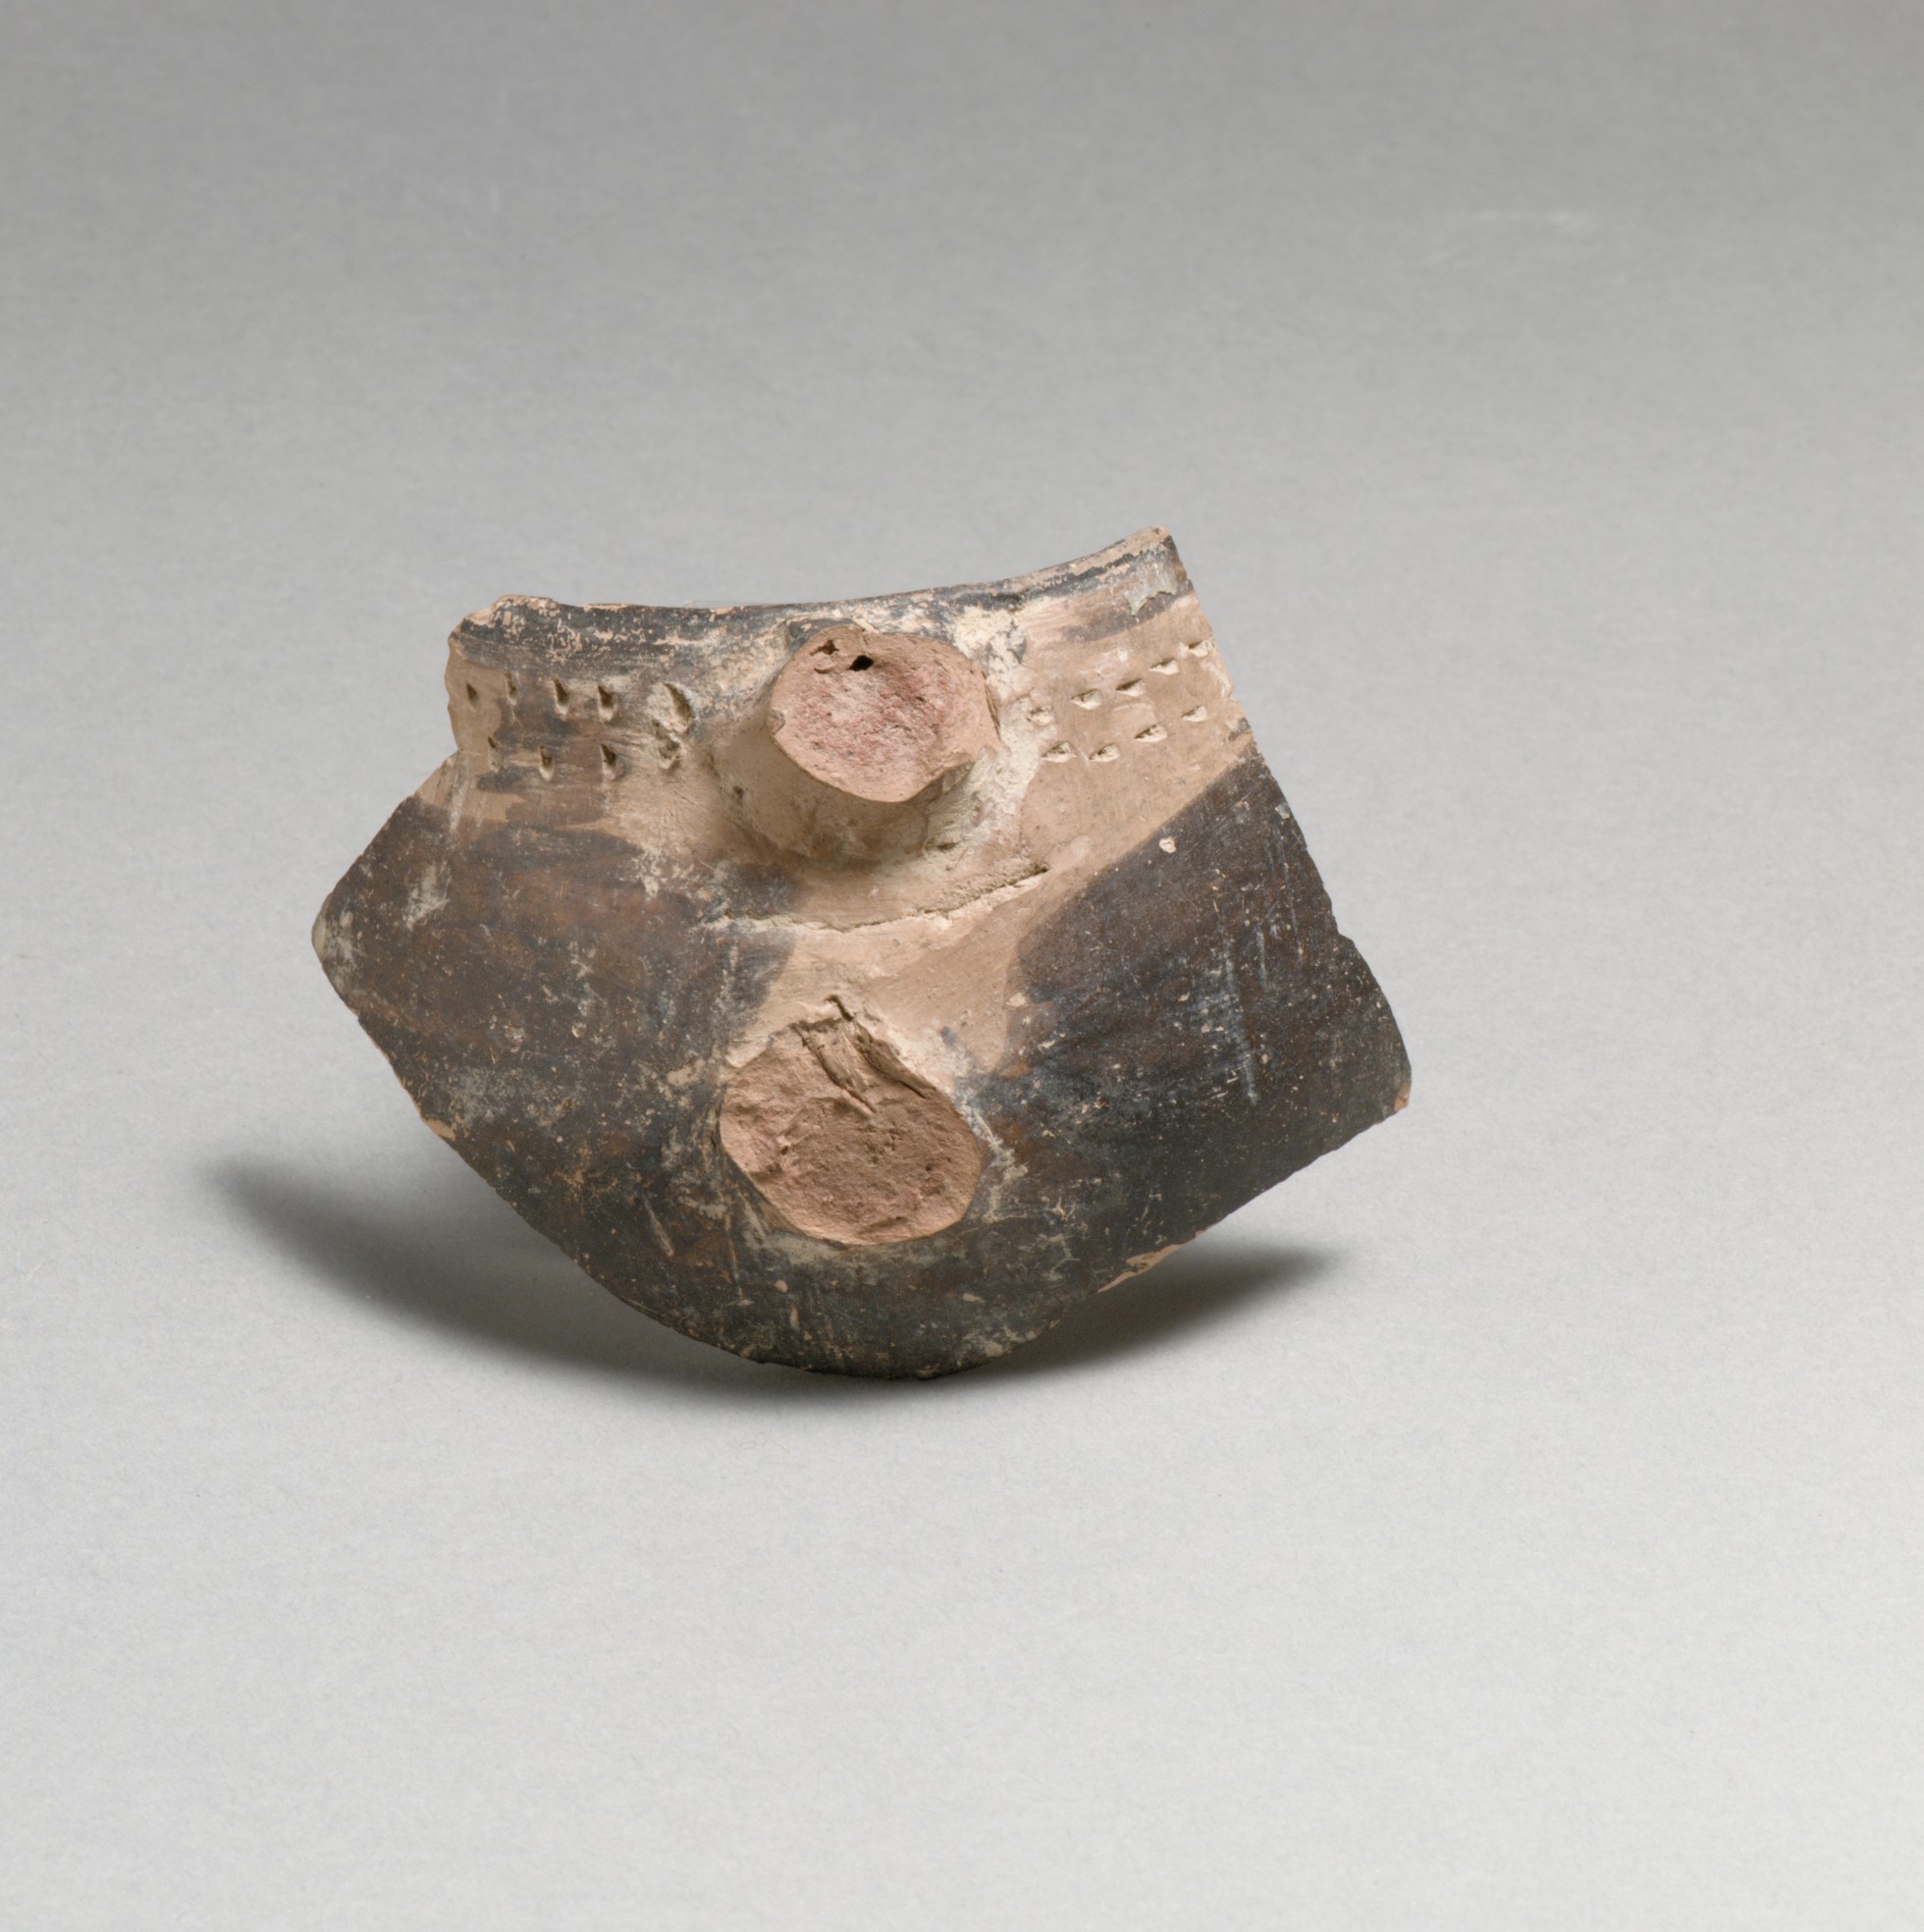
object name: vase fragment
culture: minoan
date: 2600-2000 BCE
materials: terracotta